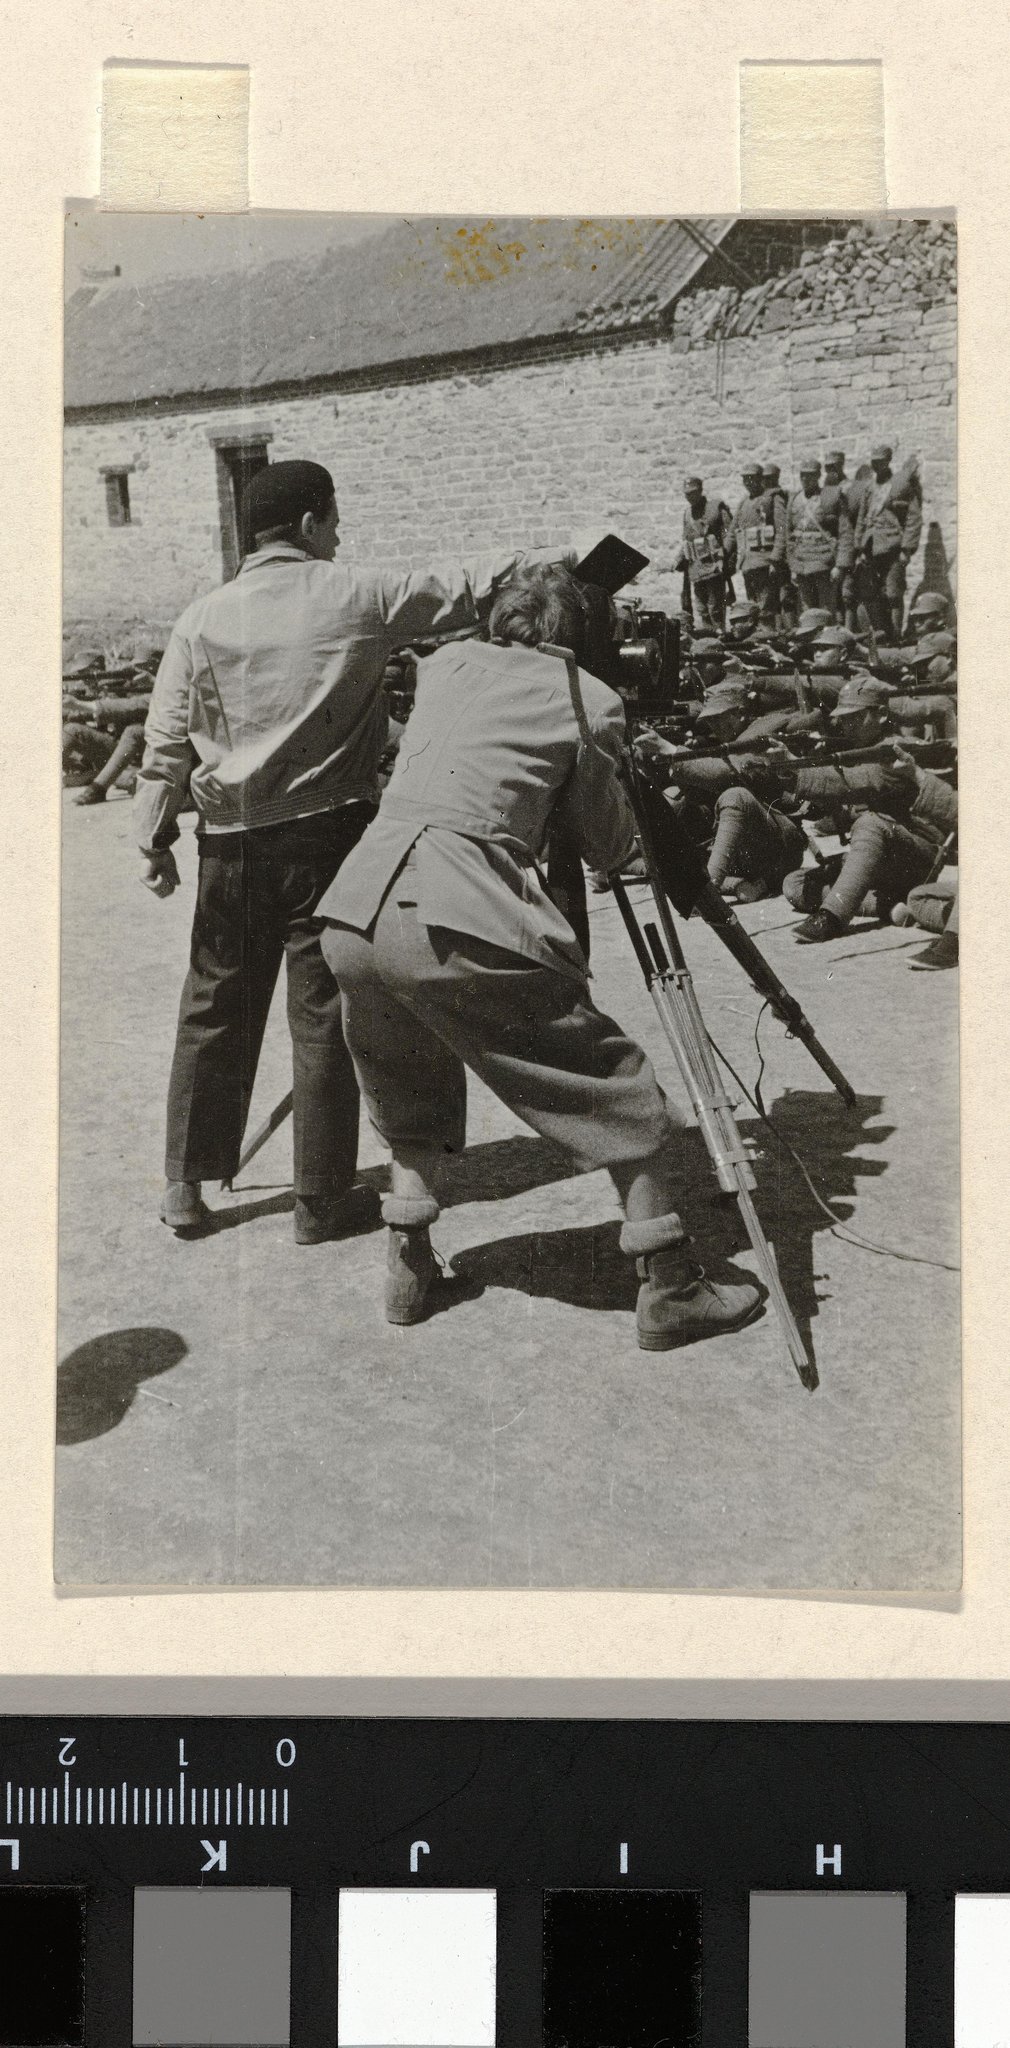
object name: photograph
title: Joris Ivens en John Fernhout achter de camera tijdens het maken van de film 'The 400 Million', China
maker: robert capa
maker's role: fotograaf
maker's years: 1913-1954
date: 1938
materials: paper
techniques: gelatin silver print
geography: china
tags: john fernhout, nijmegen, joris ivens, filming, cinematographer at work - cc - out of doors, land forces, china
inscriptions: number: ‘K 295/ K 20’, name: ‘Capa’